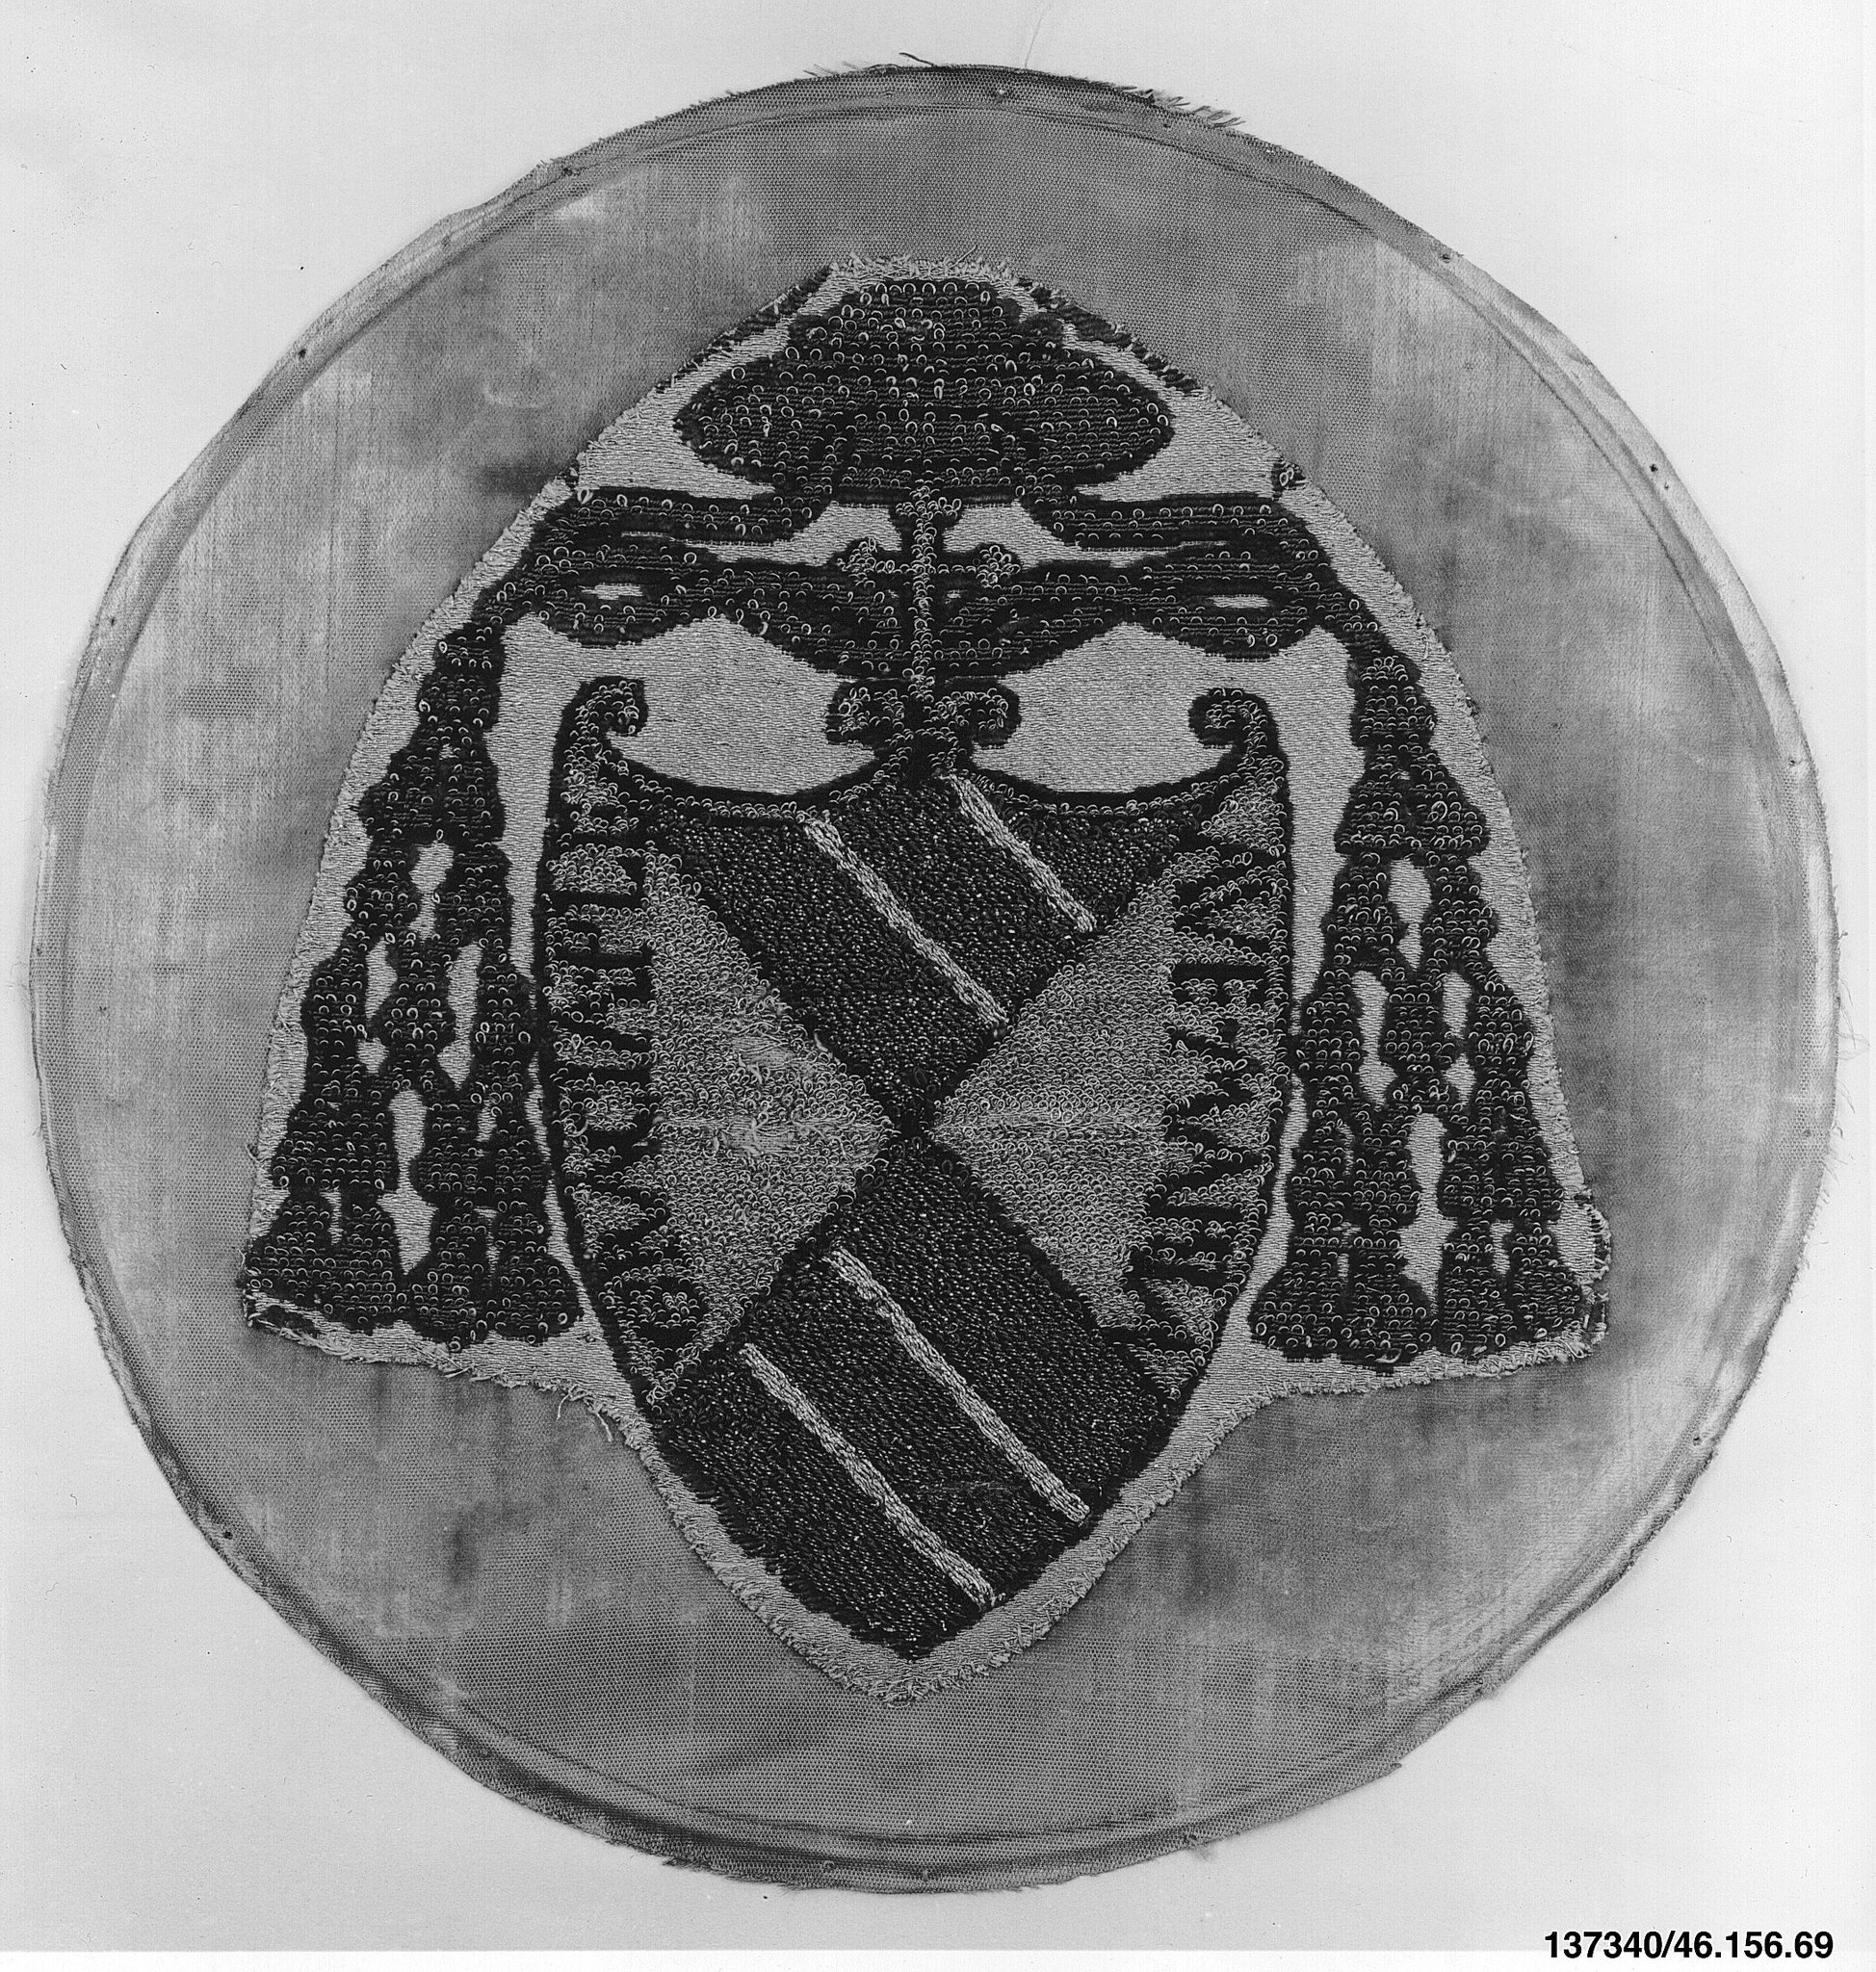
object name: piece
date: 1475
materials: metal thread, silk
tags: coat of arms